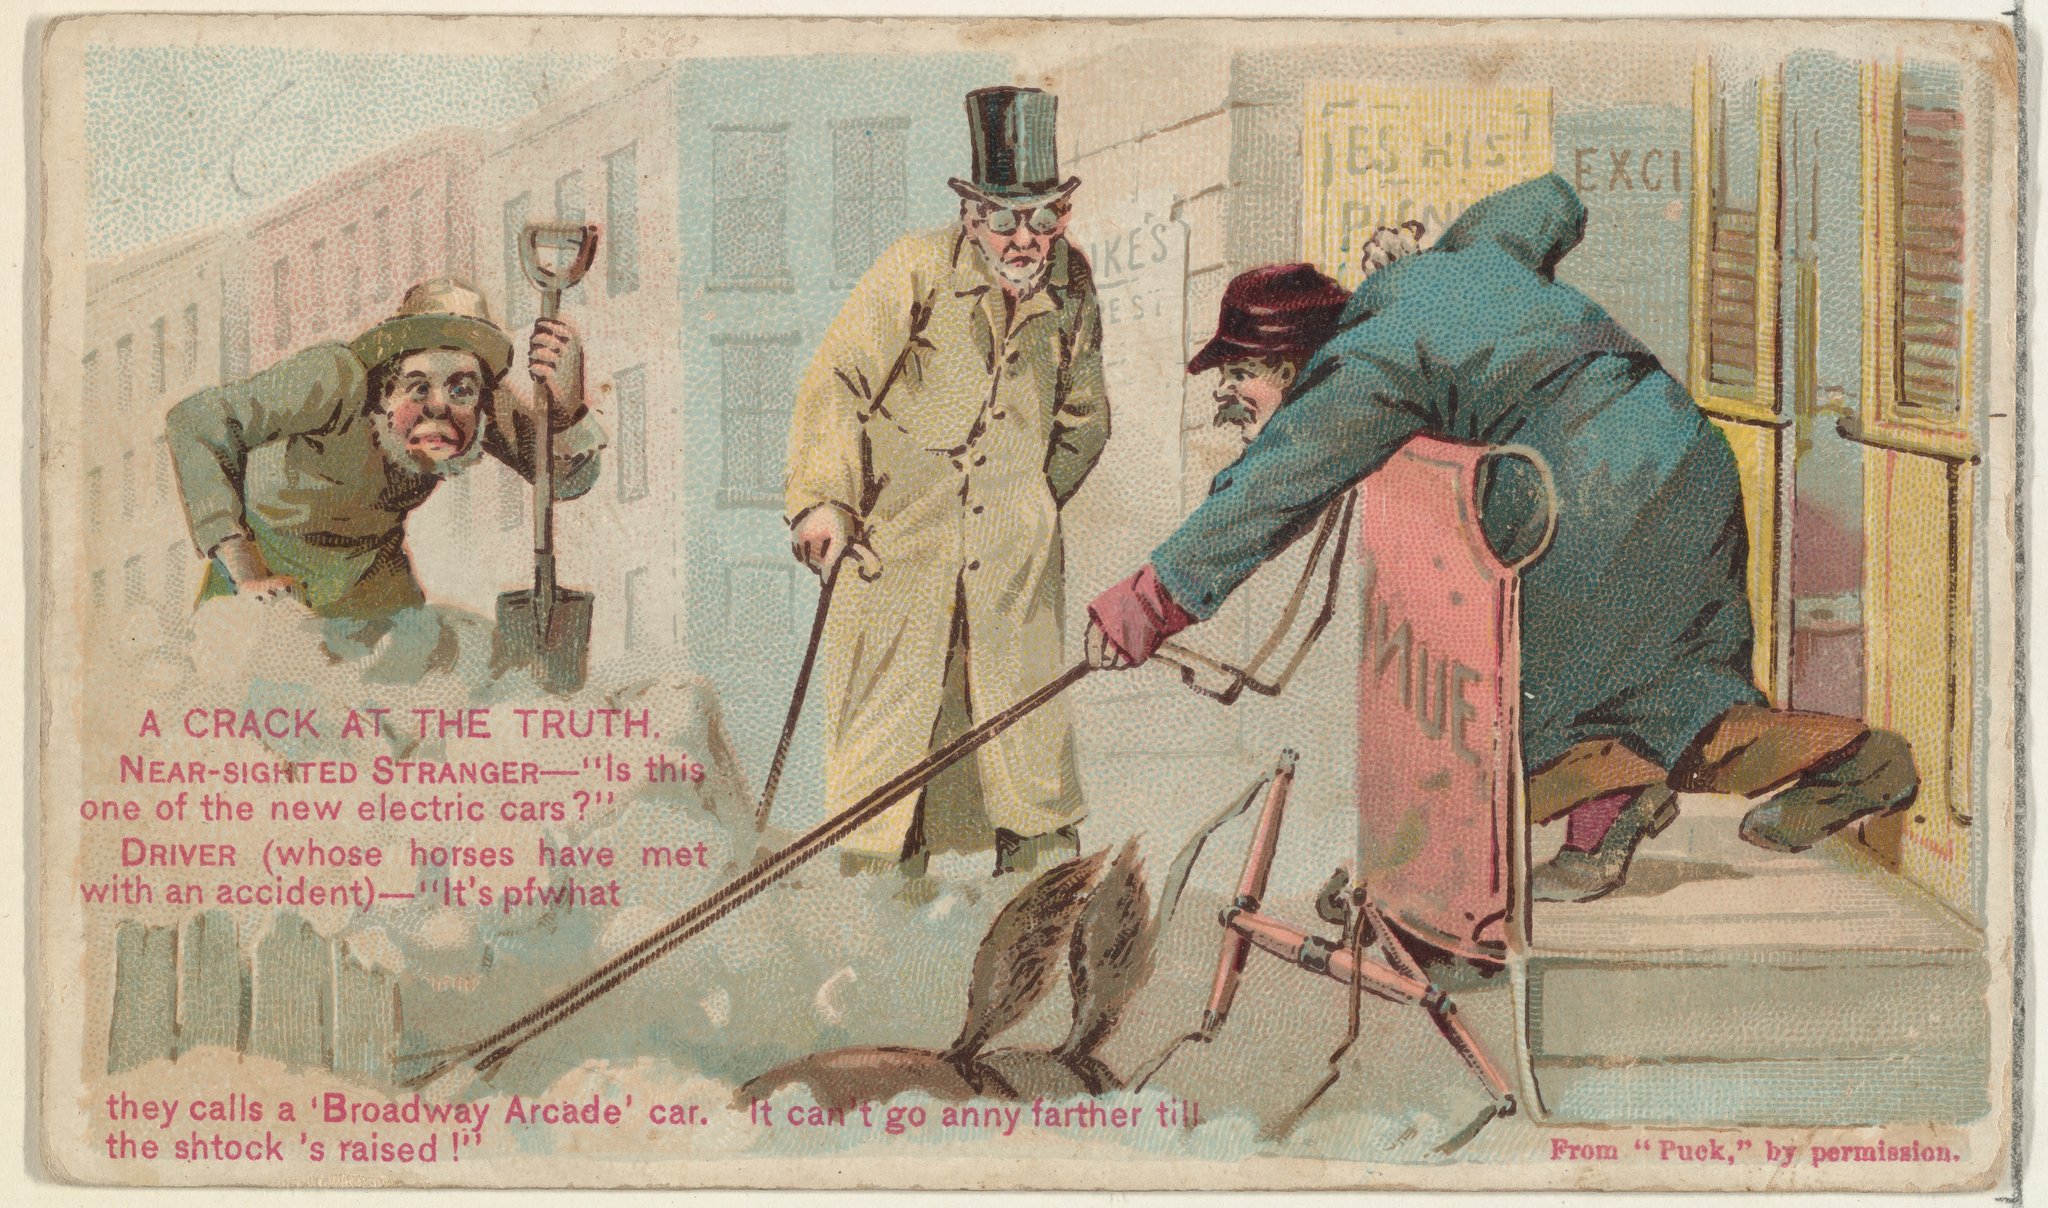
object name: print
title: A Crack at the Truth, from the Snapshots from "Puck" series (N128) issued by Duke Sons & Co. to promote Honest Long Cut Tobacco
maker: w. duke, sons & co.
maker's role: publisher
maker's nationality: american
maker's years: 1870-1920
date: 1888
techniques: color lithograph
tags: buildings,men